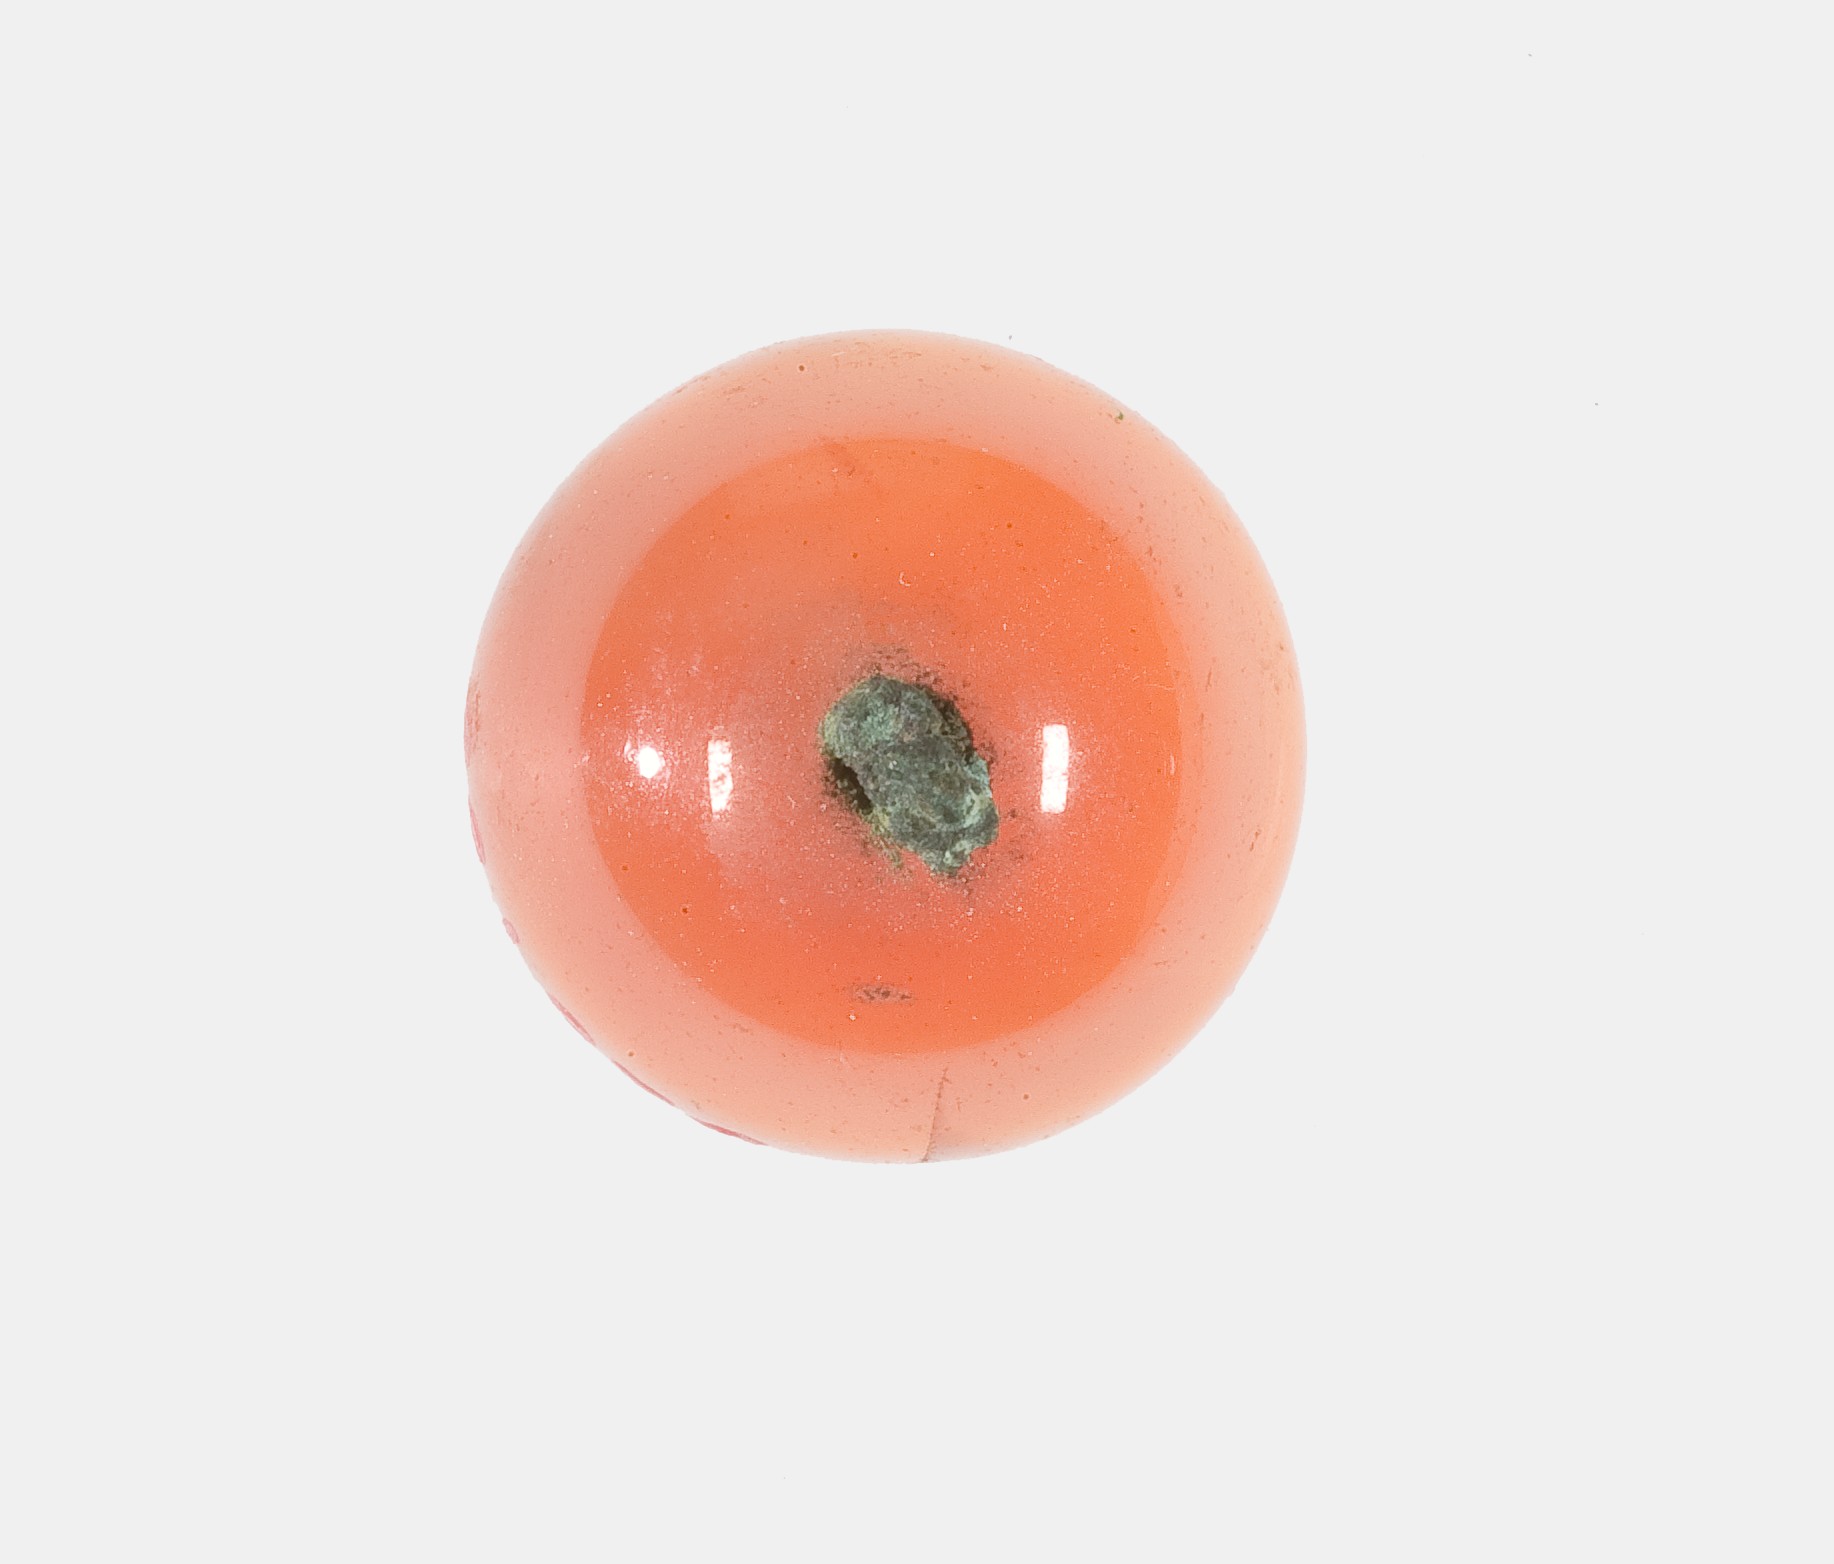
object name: pendant, round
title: Round pendant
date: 1802-1700 BCE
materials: gemstone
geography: egypt